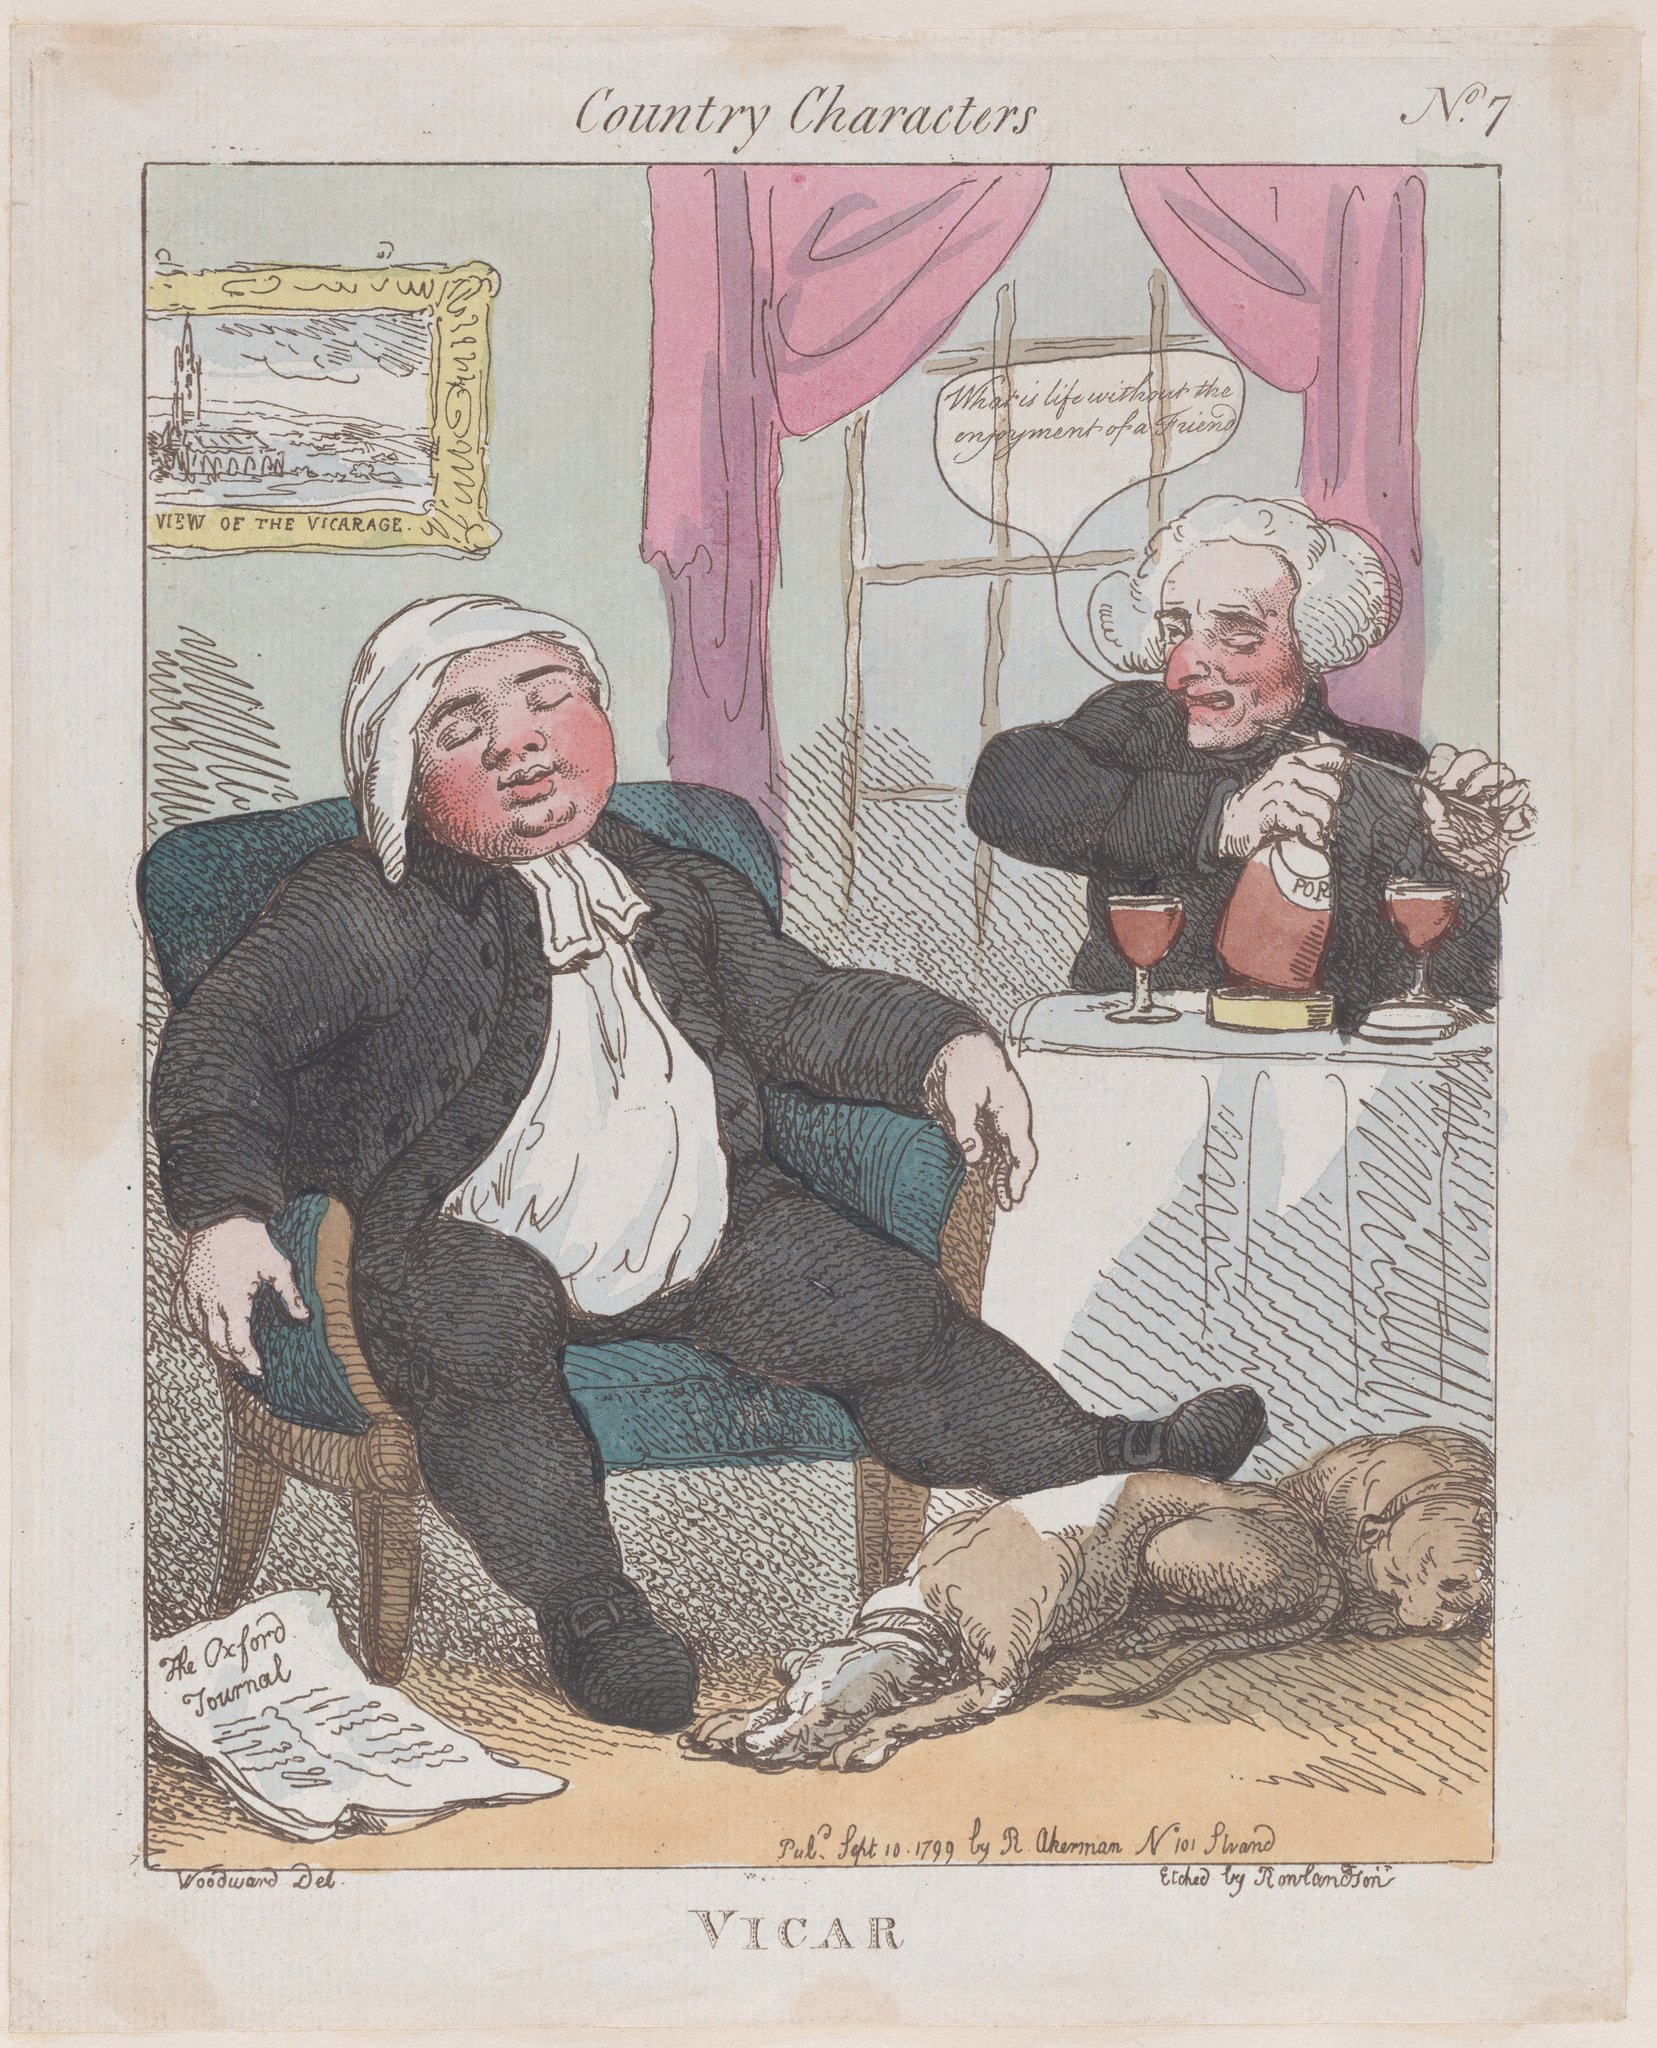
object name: print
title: Vicar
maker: thomas rowlandson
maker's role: artist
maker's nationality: british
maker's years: 1757-1827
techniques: etching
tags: satire,sleeping,men,dogs